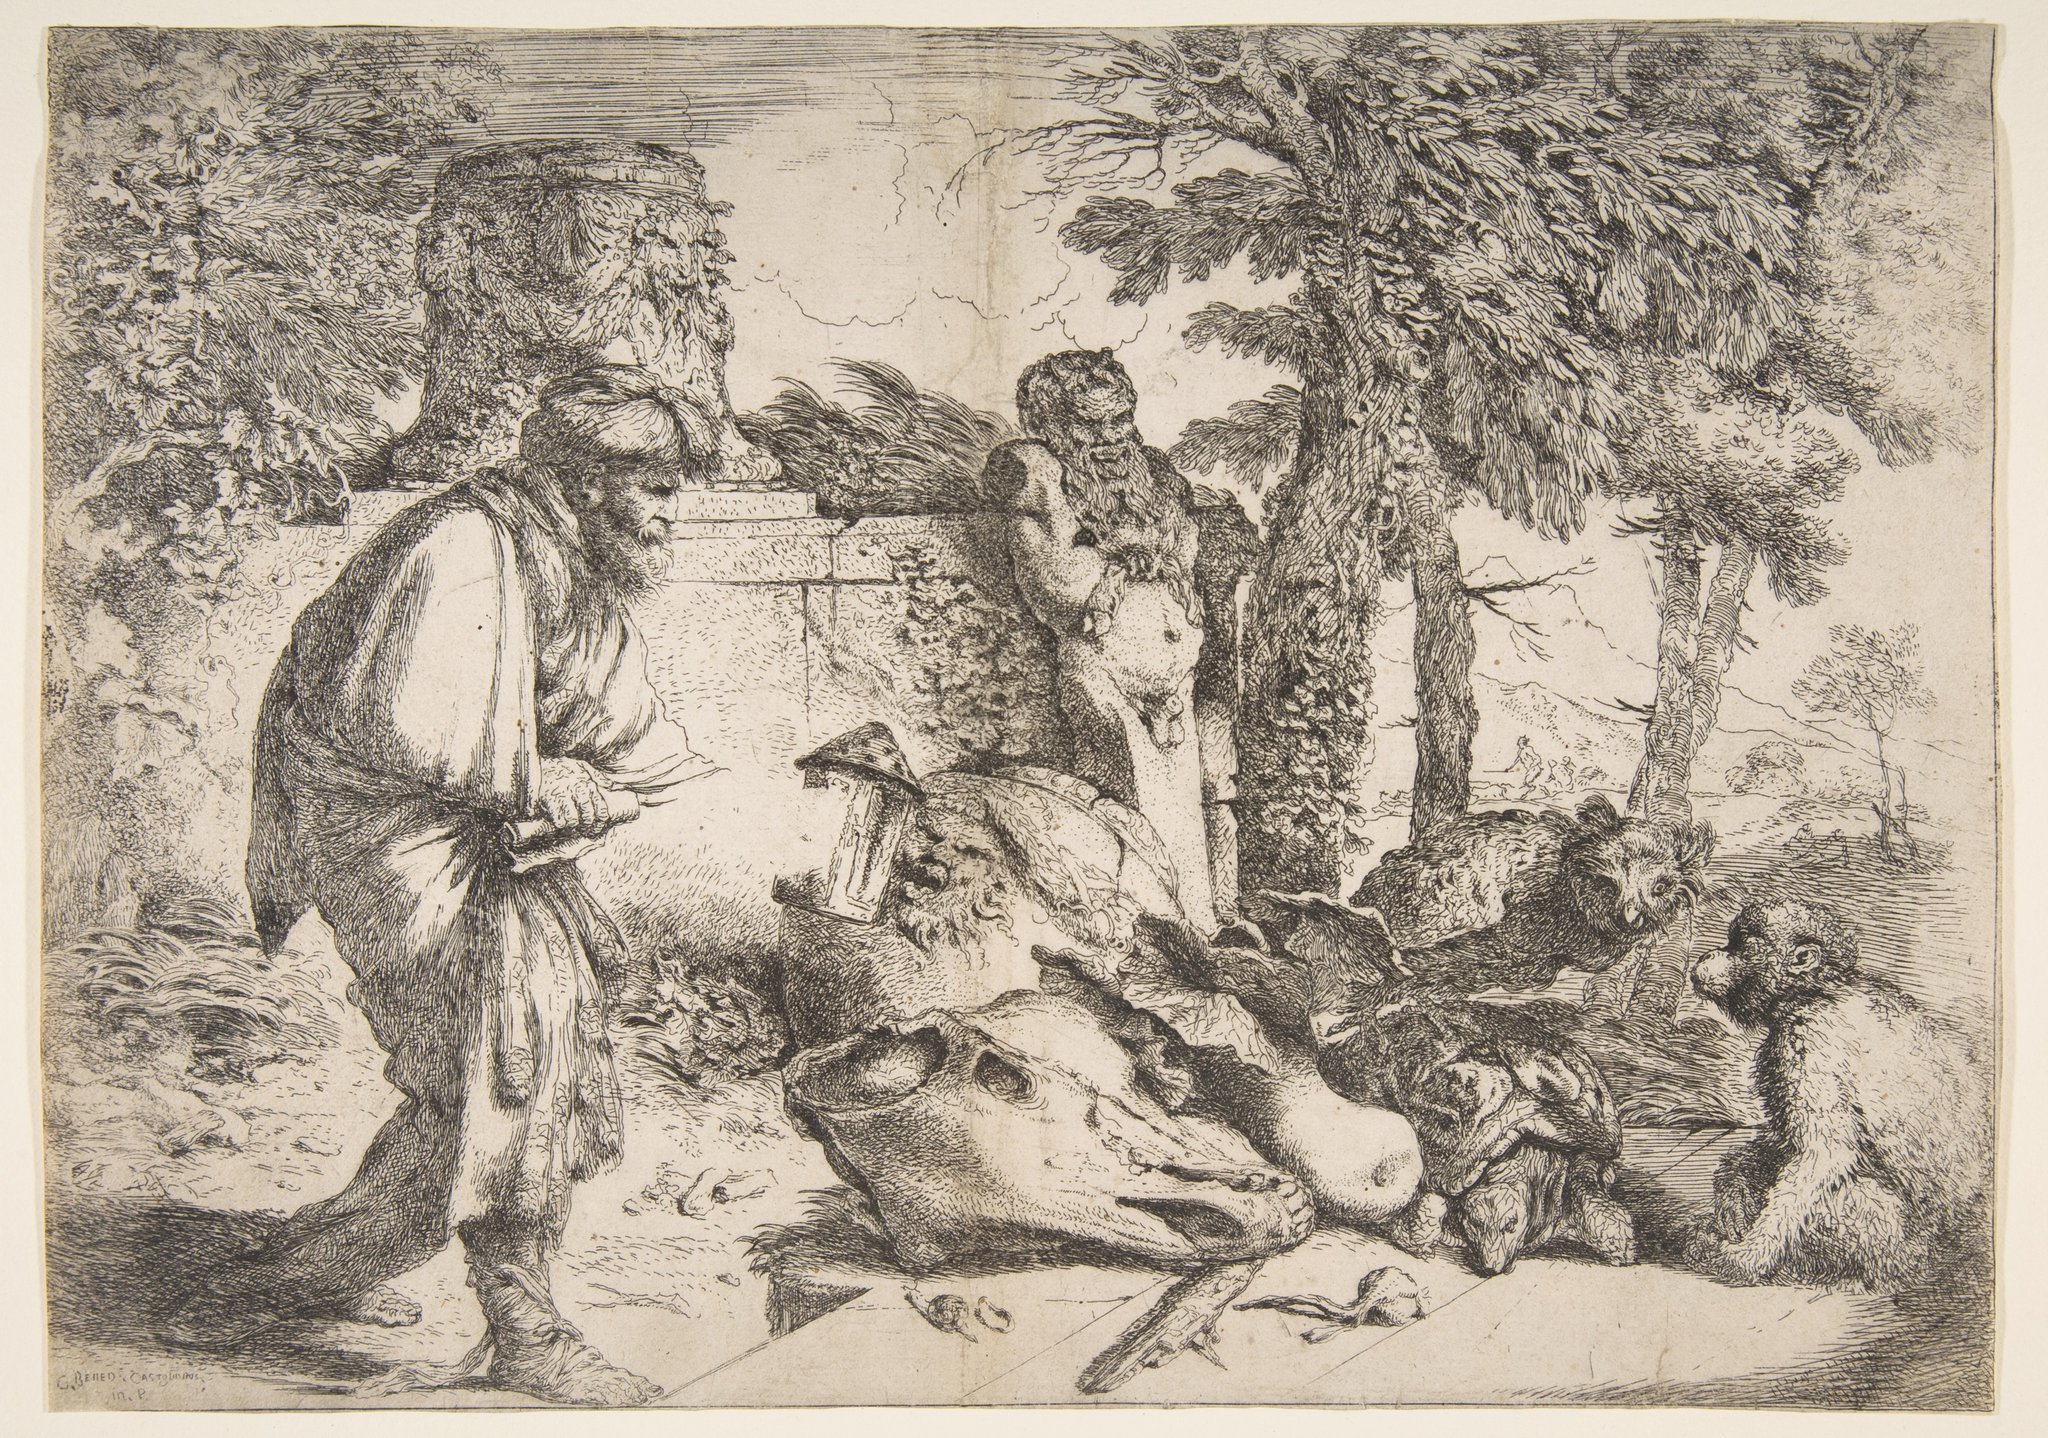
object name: print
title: Diogenes in search of an honest man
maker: giovanni benedetto castiglione (il grechetto)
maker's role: artist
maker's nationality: italian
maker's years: 1609-1664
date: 1645-1647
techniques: etching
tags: animals,diogenes,trees